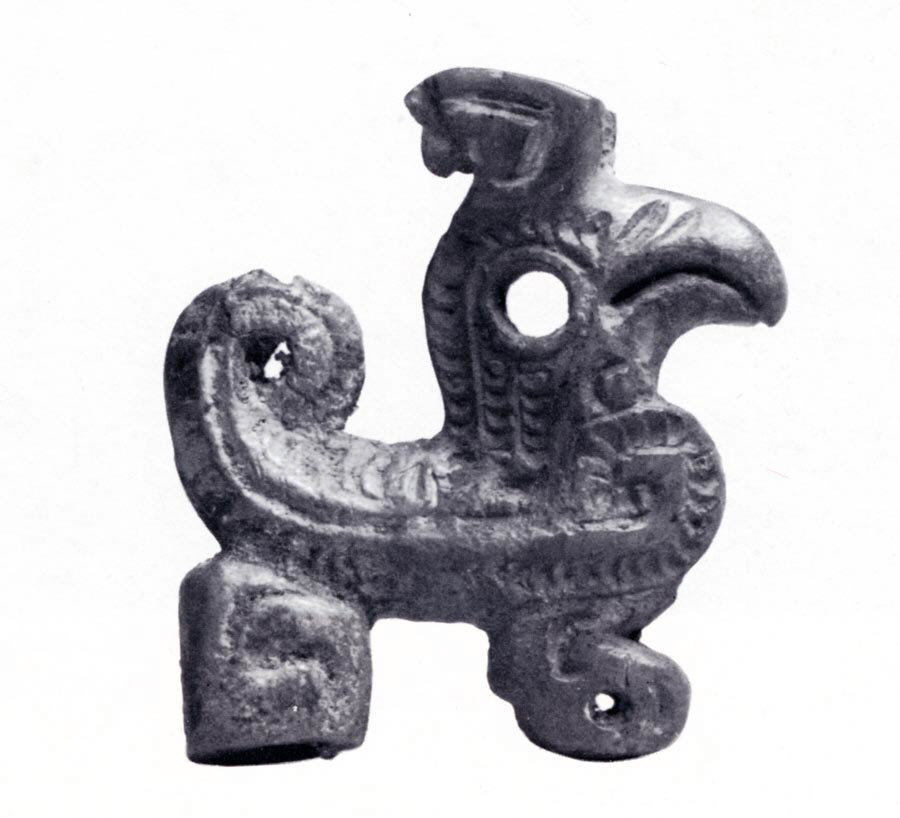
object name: hairpin finial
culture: chinese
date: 1600-1046 BCE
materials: bone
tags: birds